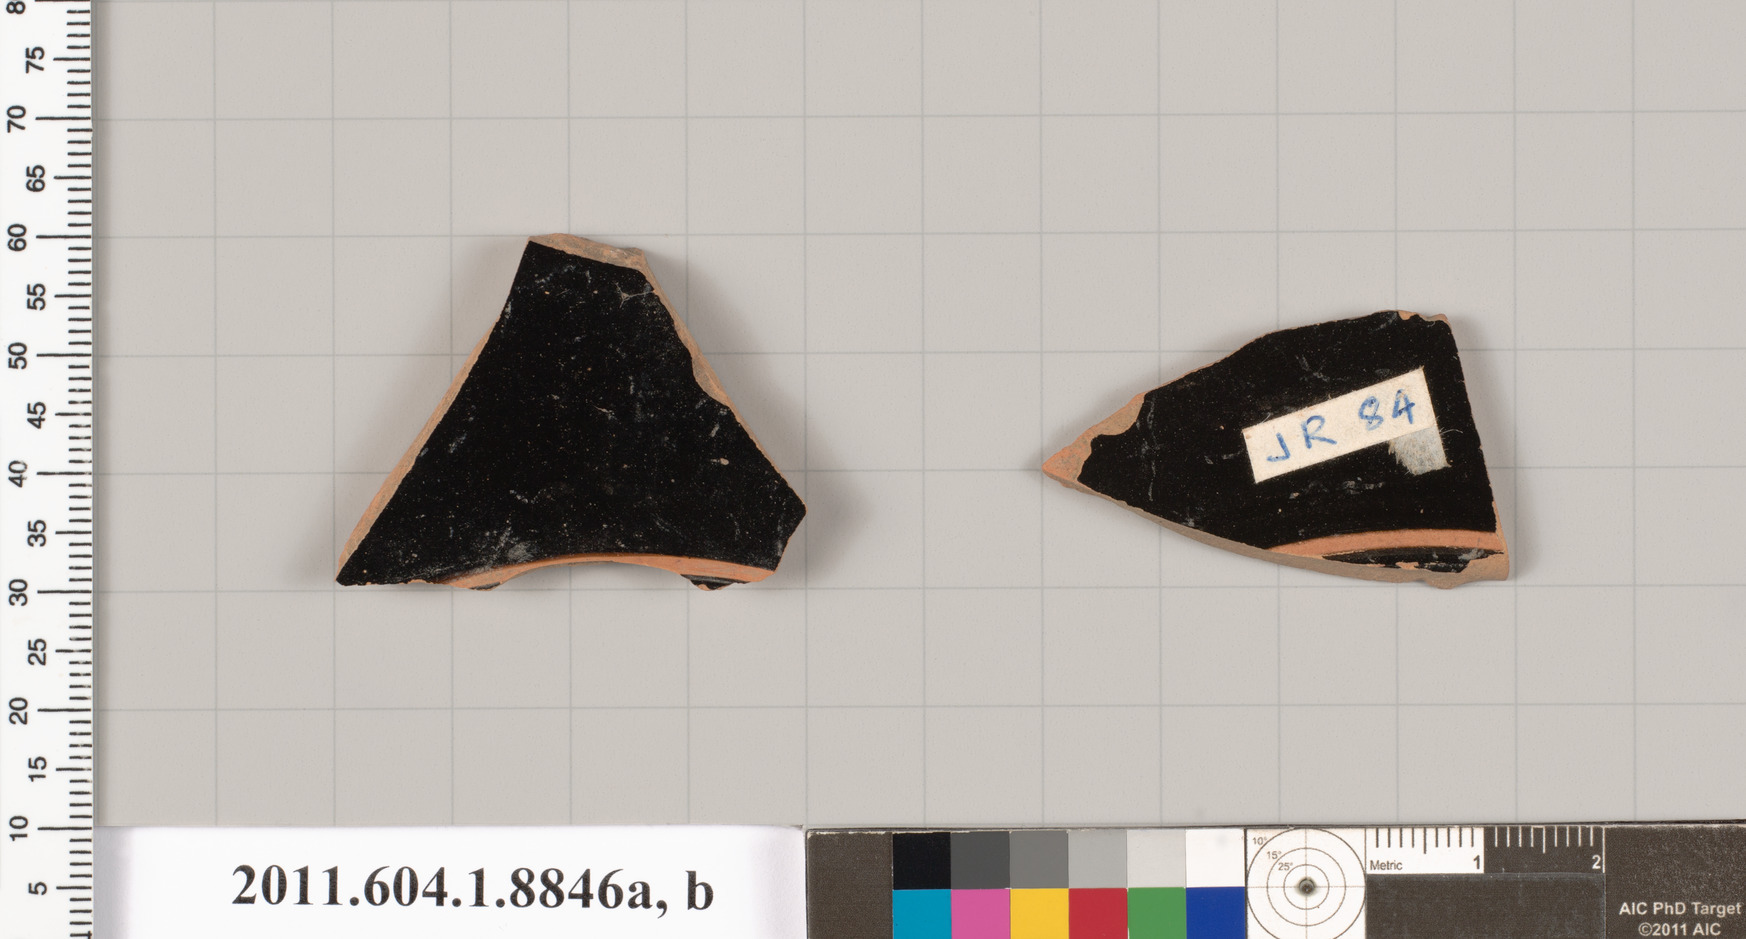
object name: kylix fragment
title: Terracotta fragments of kylikes (drinking cups)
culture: greek, attic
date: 500-470 BCE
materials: terracotta